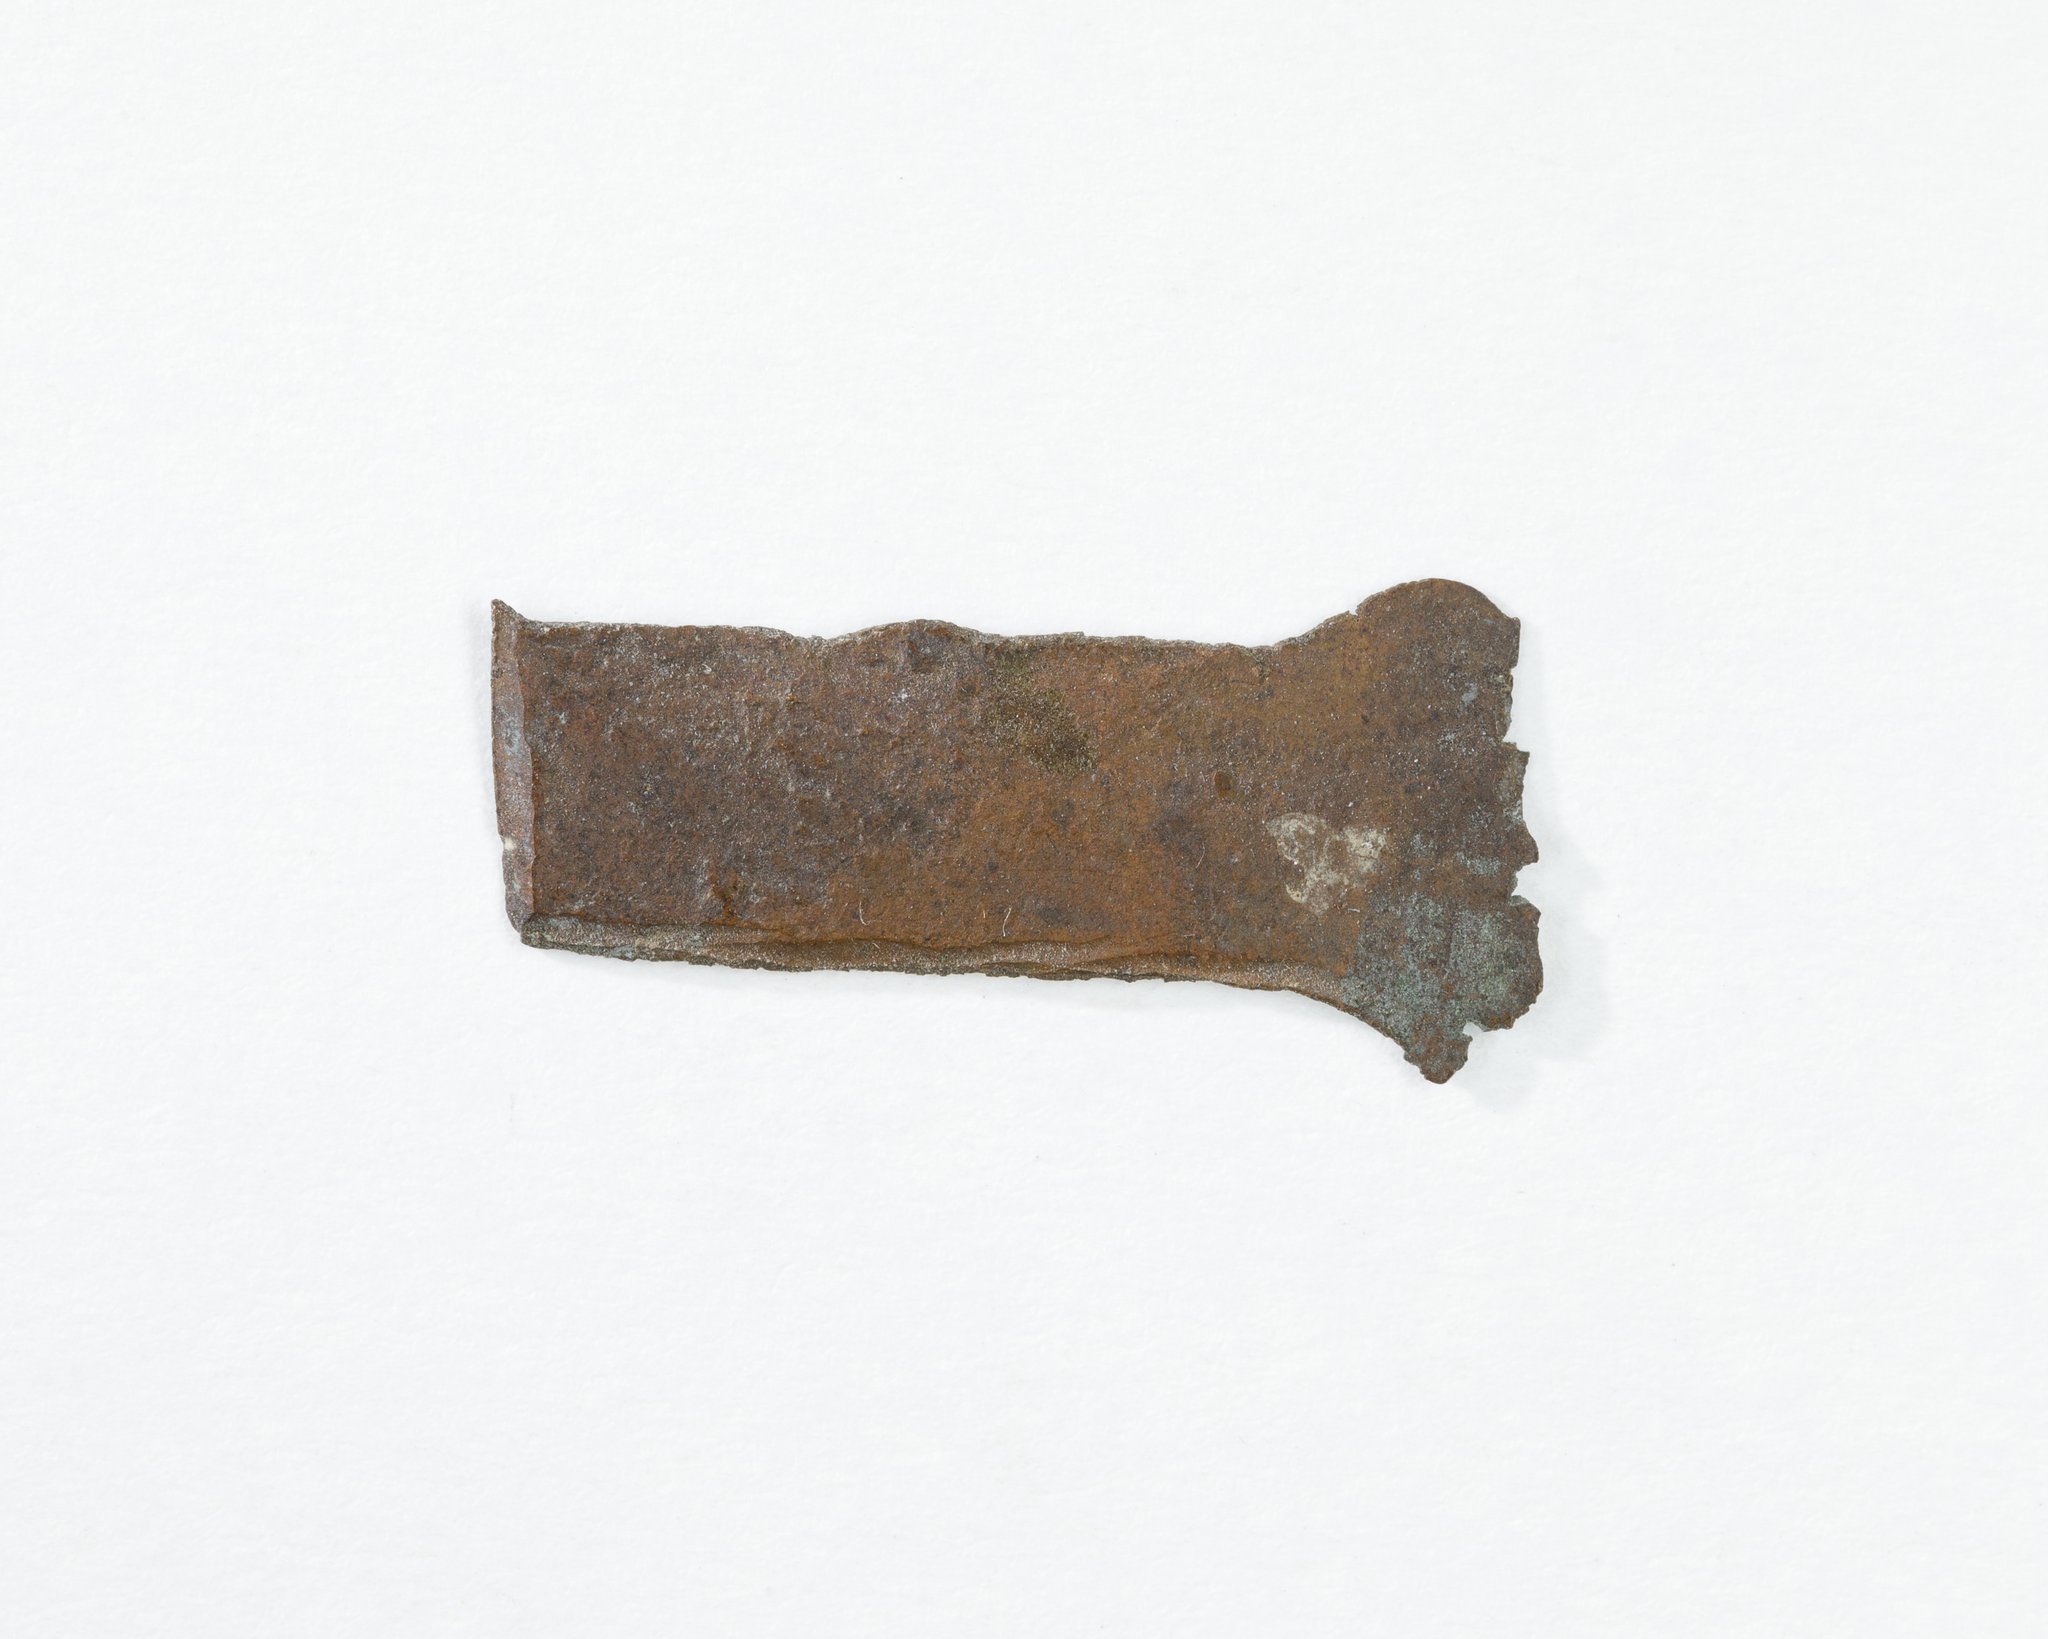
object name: ax blade, model, tool, senenmut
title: Blade for a Model Axe from a Foundation Deposit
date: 1479-1458 BCE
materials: bronze, copper alloy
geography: egypt